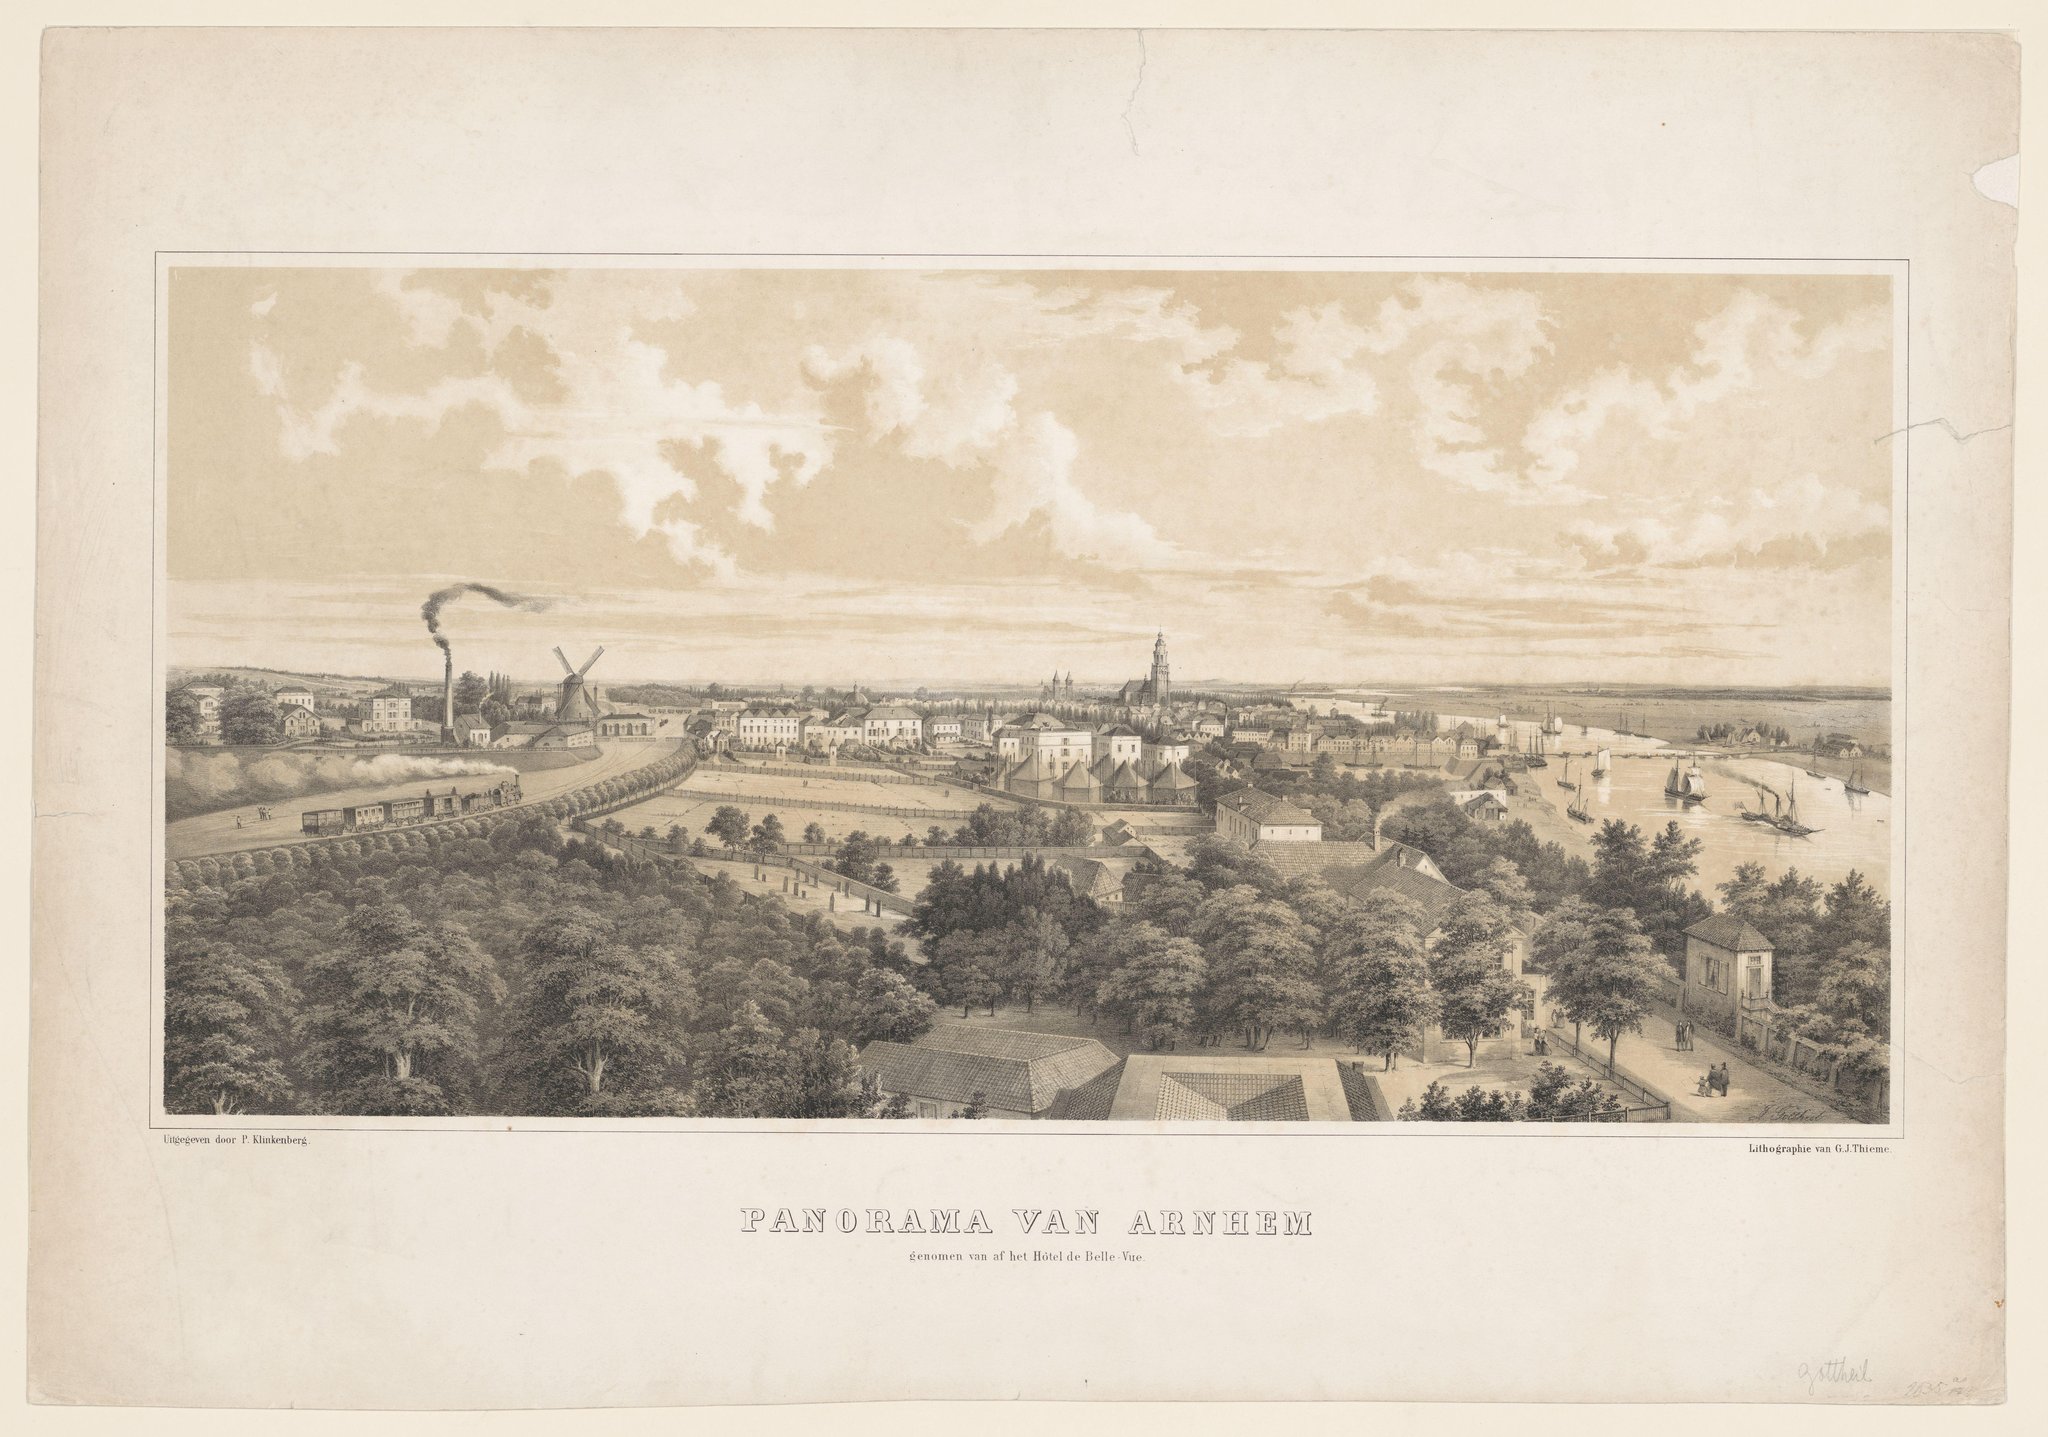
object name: print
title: Gezicht op Arnhem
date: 1837-1864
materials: paper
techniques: tone lithography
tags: city-view in general; 'veduta'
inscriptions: collector's mark: Lugt 2228